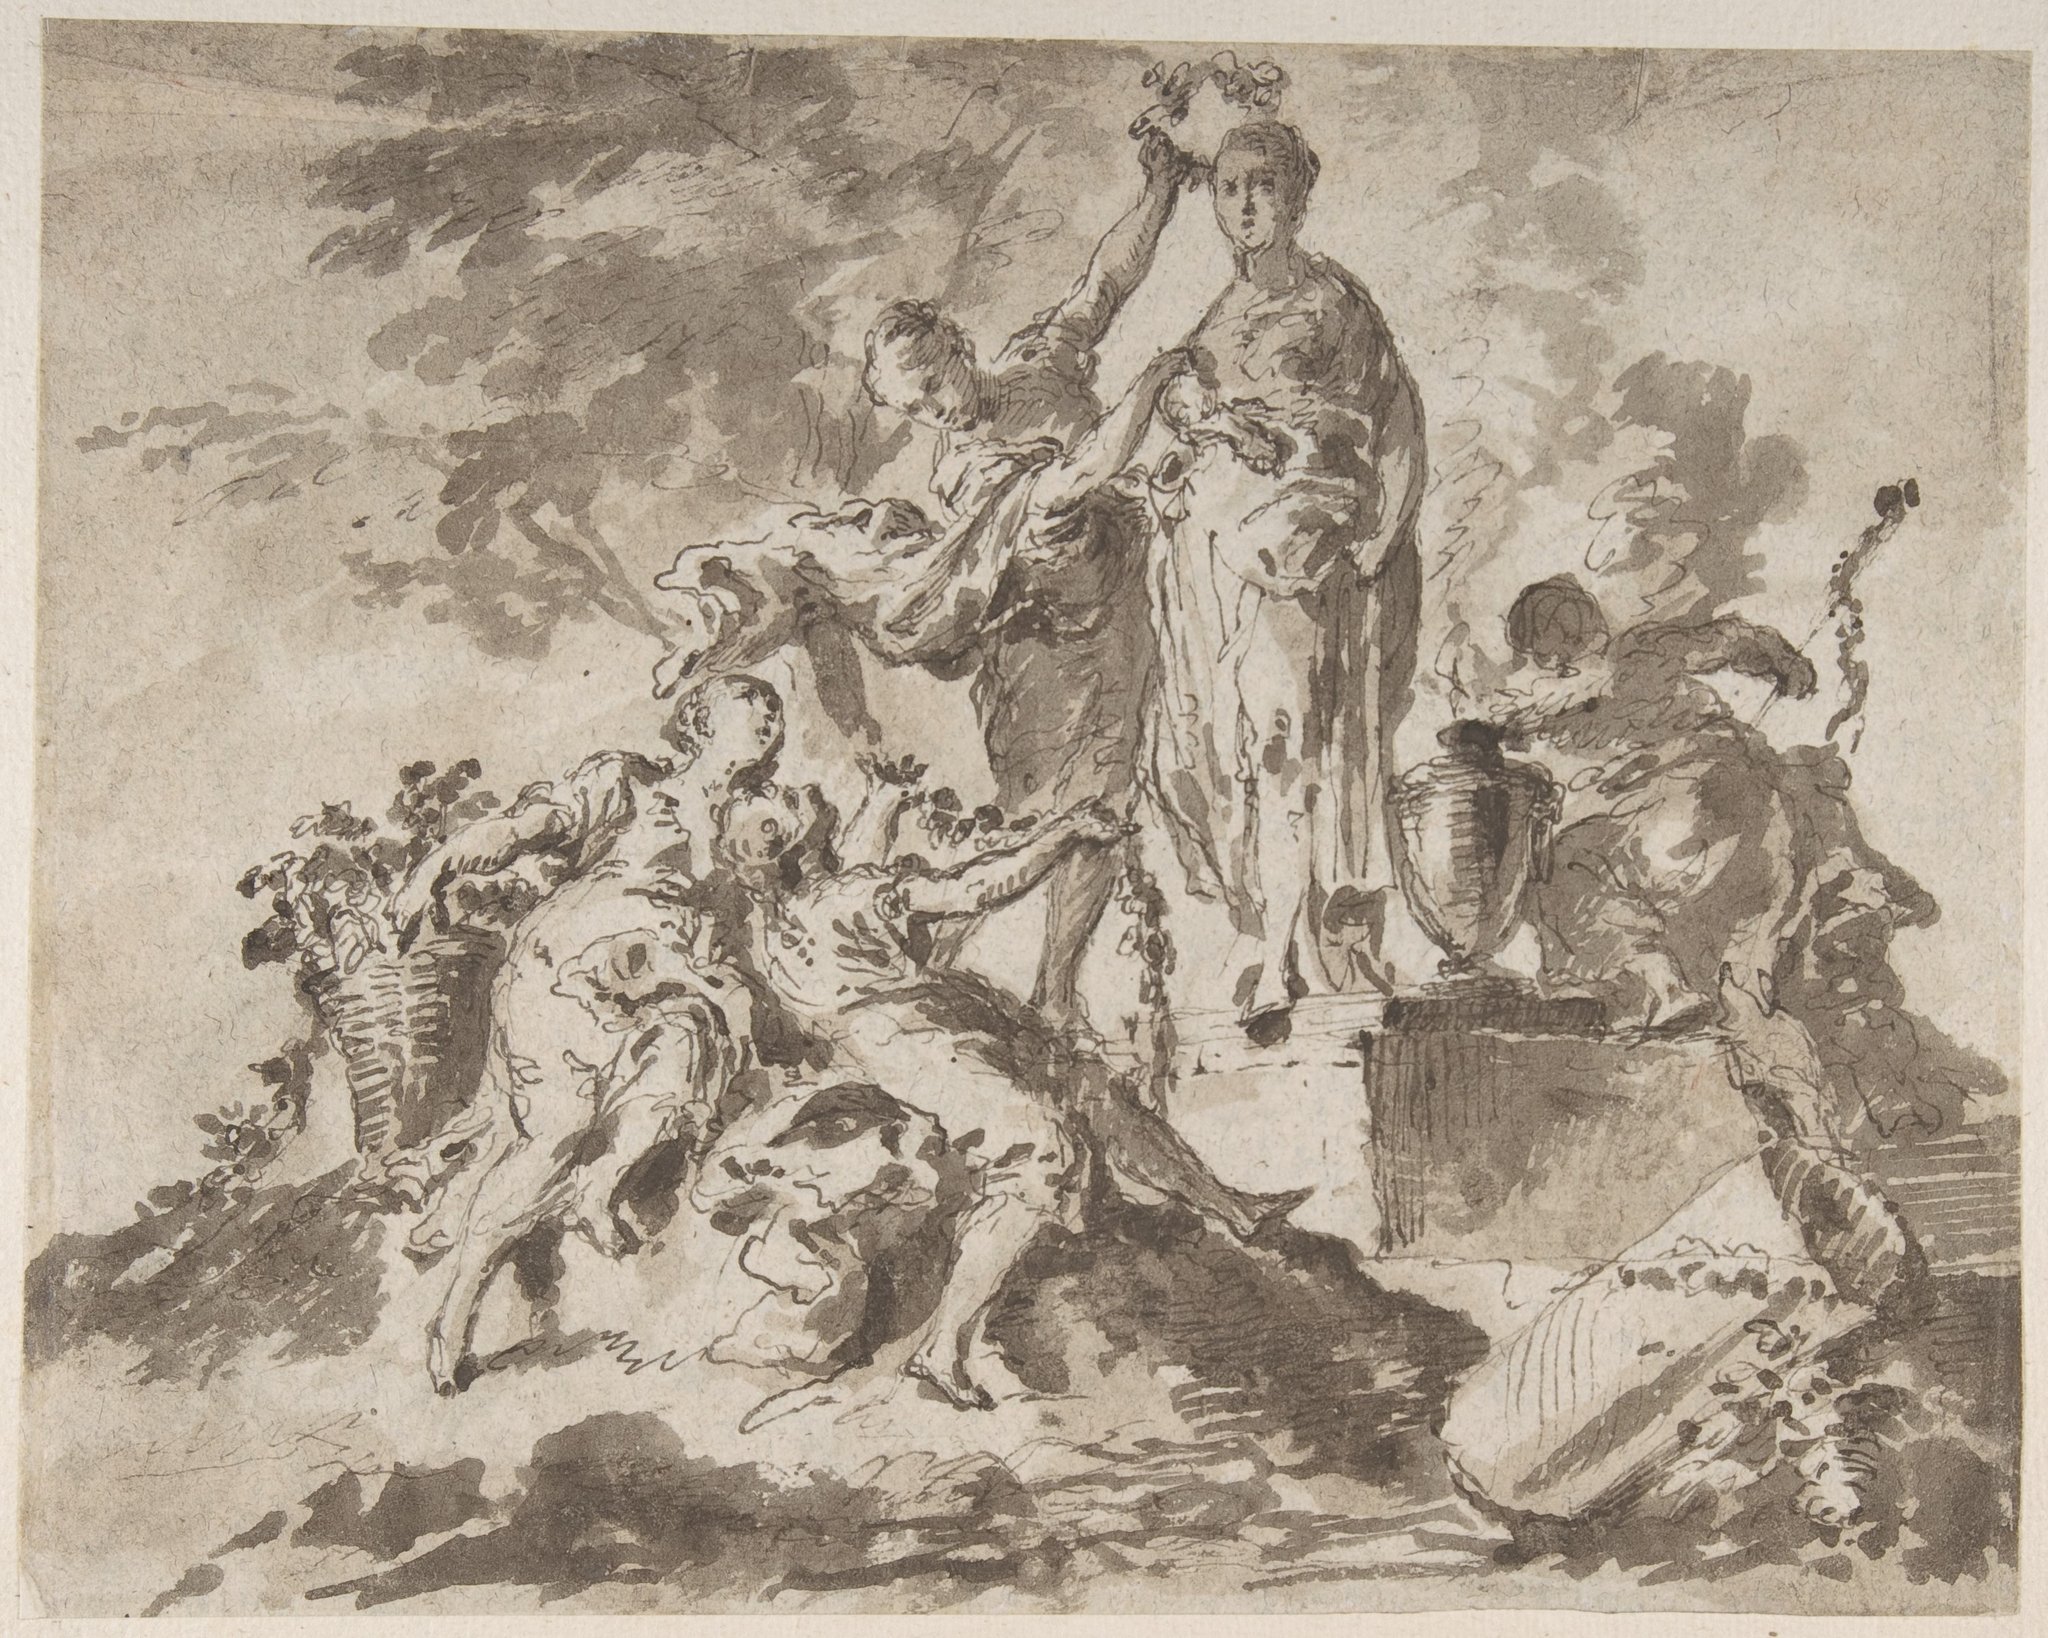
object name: drawing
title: Nymphs Adorning the Statue of a Goddess (recto); River God with Three Nymphs (verso)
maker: anonymous, italian, venetian, 18th century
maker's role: artist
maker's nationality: italian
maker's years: 1700-1800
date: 1701-1800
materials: ink, paper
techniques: brush, pen, wash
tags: nymphs,goddess